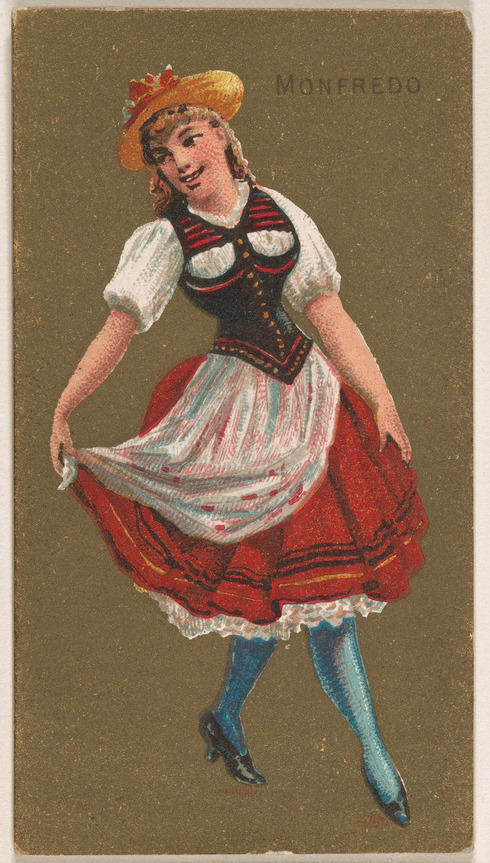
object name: print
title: Manfredo, from National Dances (N225, Type 2) issued by Kinney Bros.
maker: kinney brothers tobacco company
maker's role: publisher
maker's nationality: american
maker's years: 1869-2011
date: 1889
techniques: color lithograph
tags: women,dancing,dancers